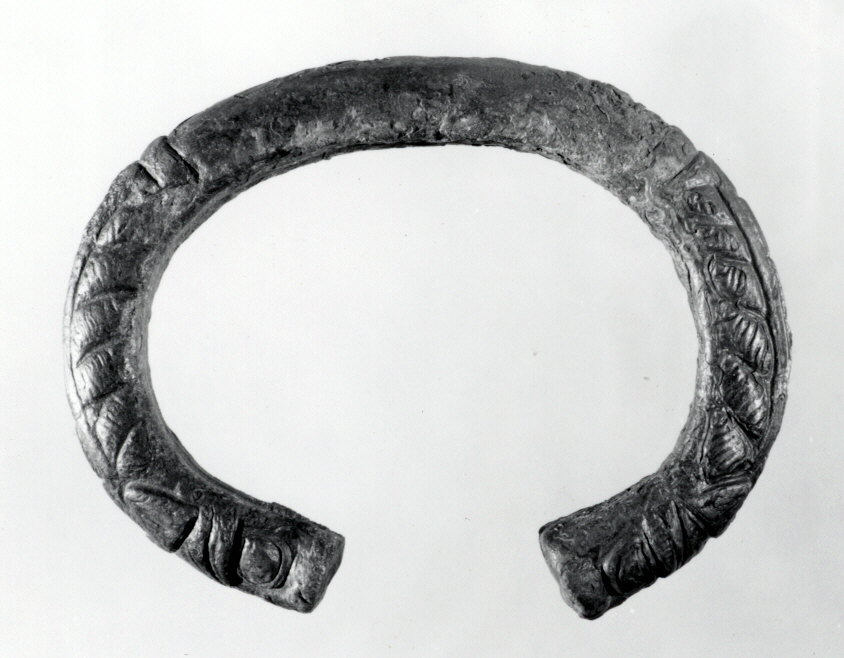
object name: bracelet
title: Bracelet with lion's-head terminals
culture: iranian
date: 800-601 BCE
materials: iron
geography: western iran